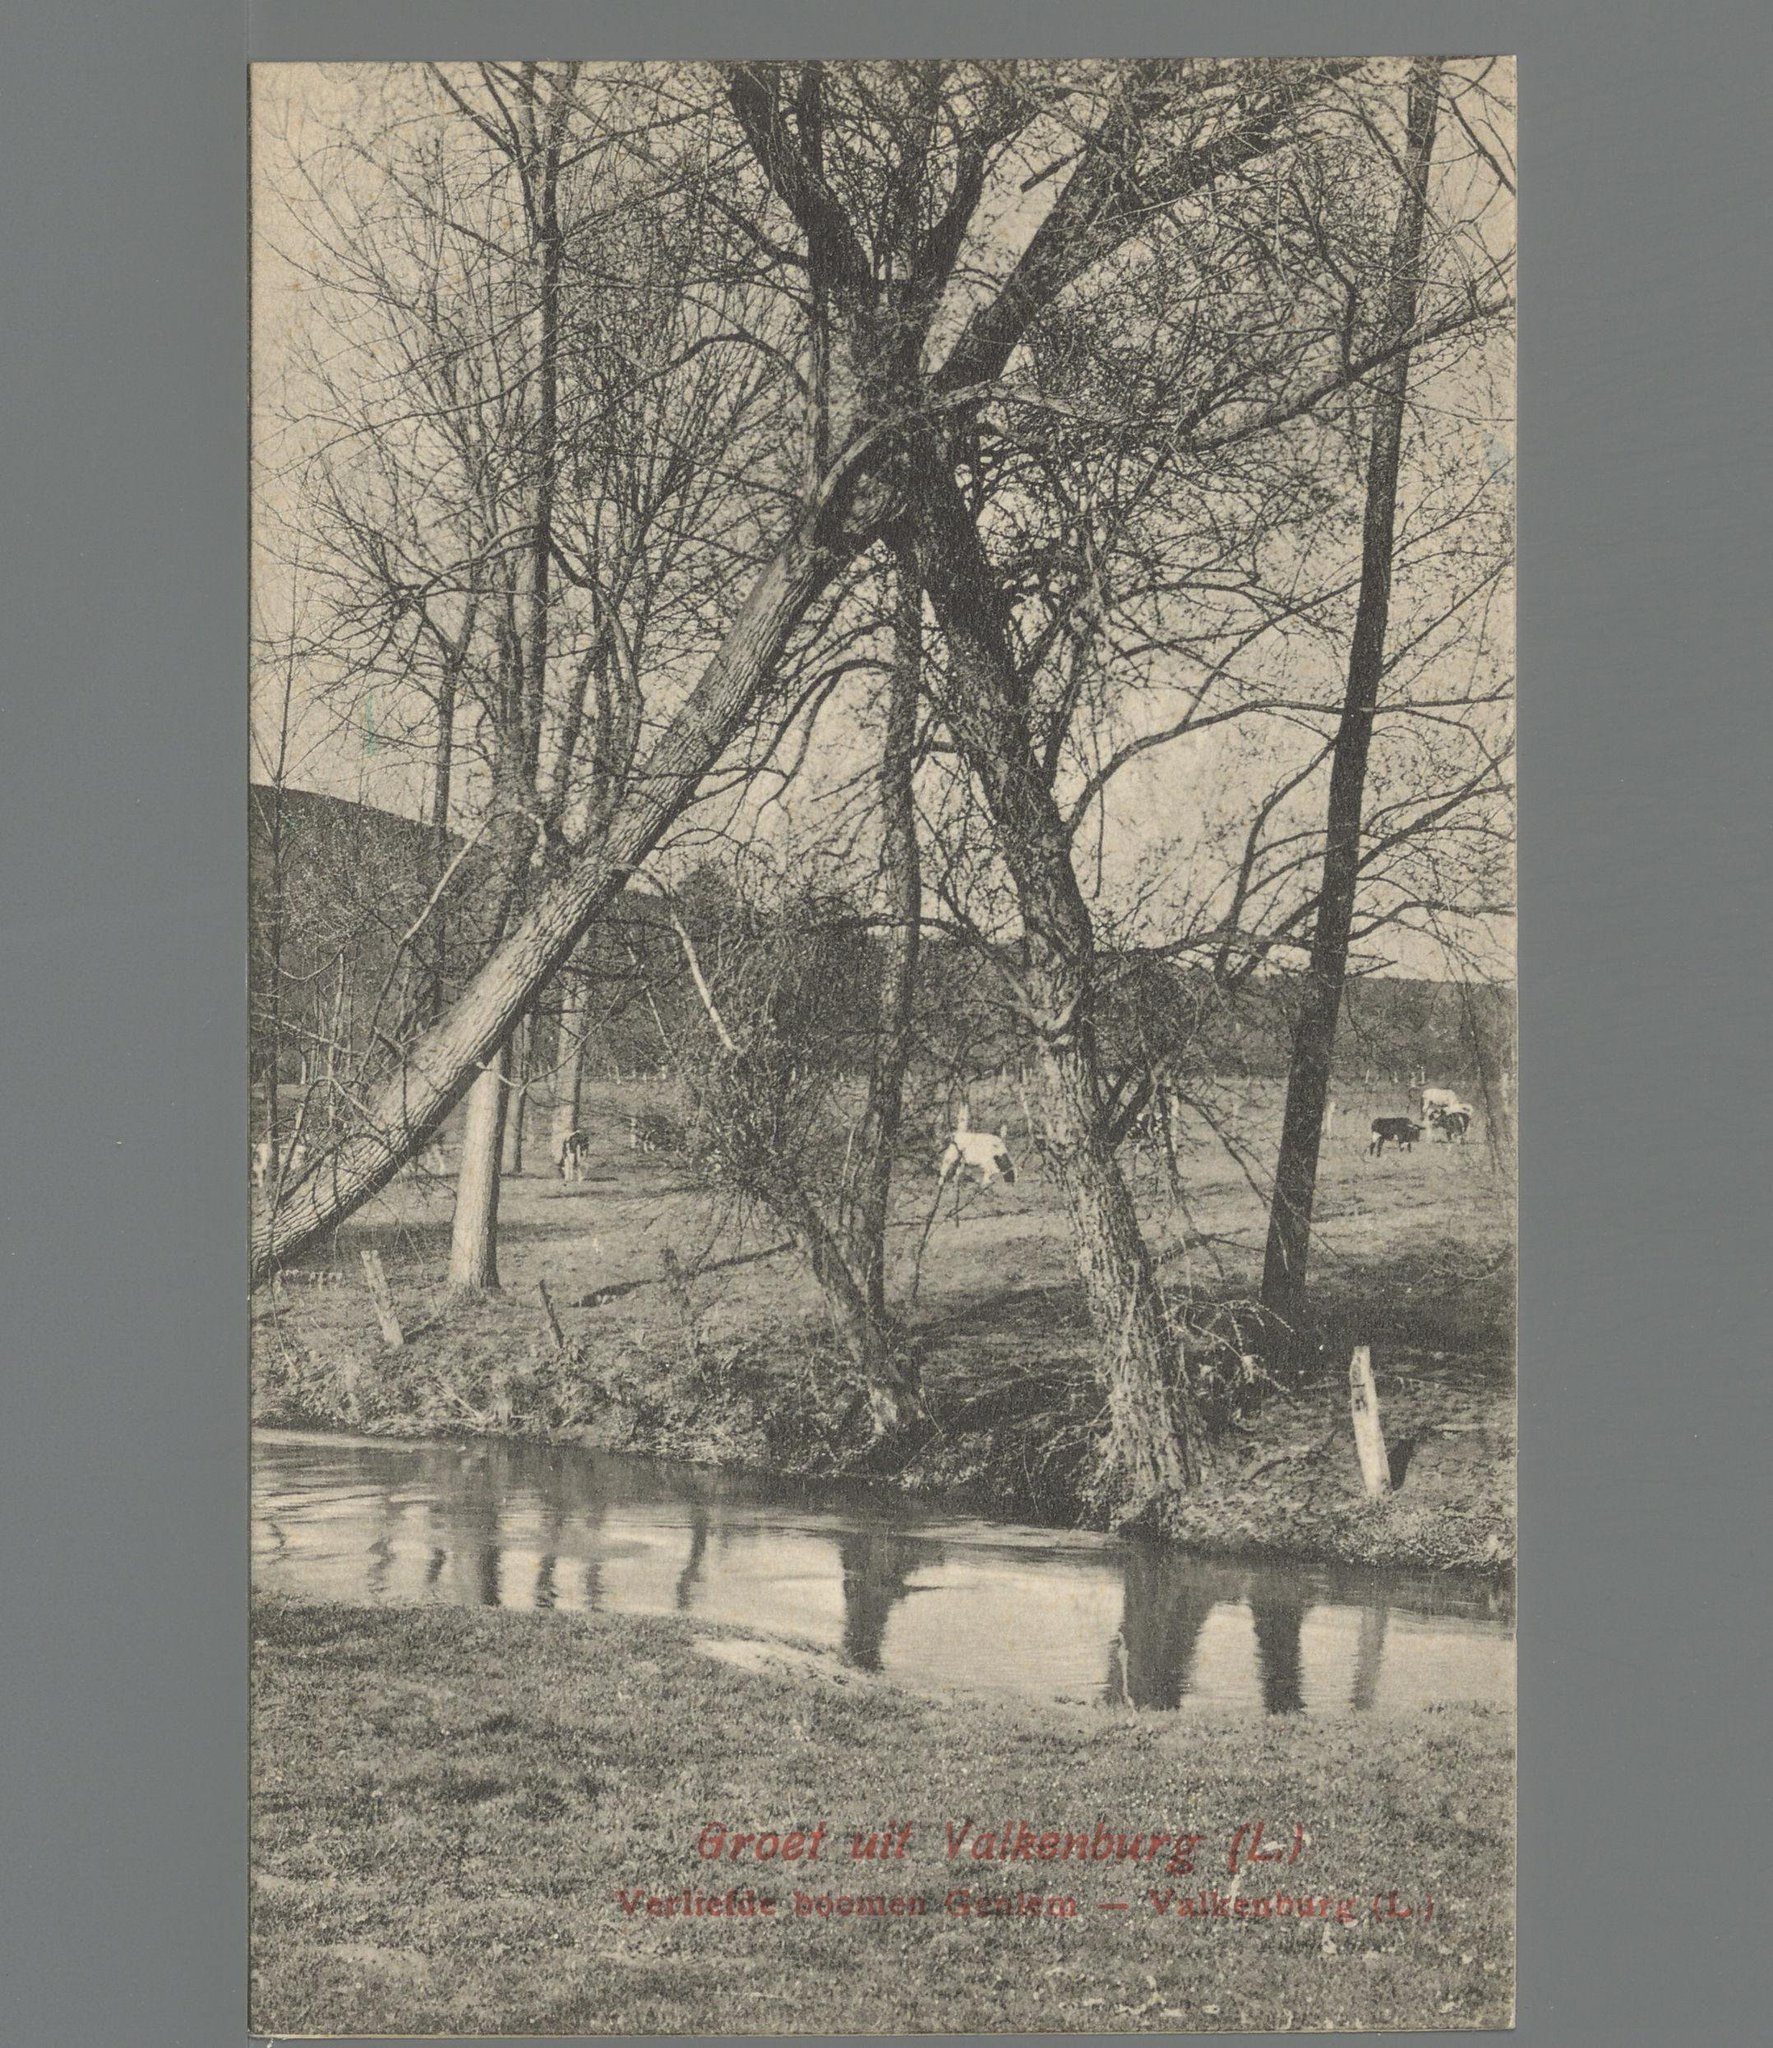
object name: ansichtkaart, prentbriefkaart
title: Groet uit Valkenburg (L). Verliefde boomen Genlem - Valkenburg (L.)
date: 1905-1926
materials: cardboard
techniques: photograph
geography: valkenburg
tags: trees, canal